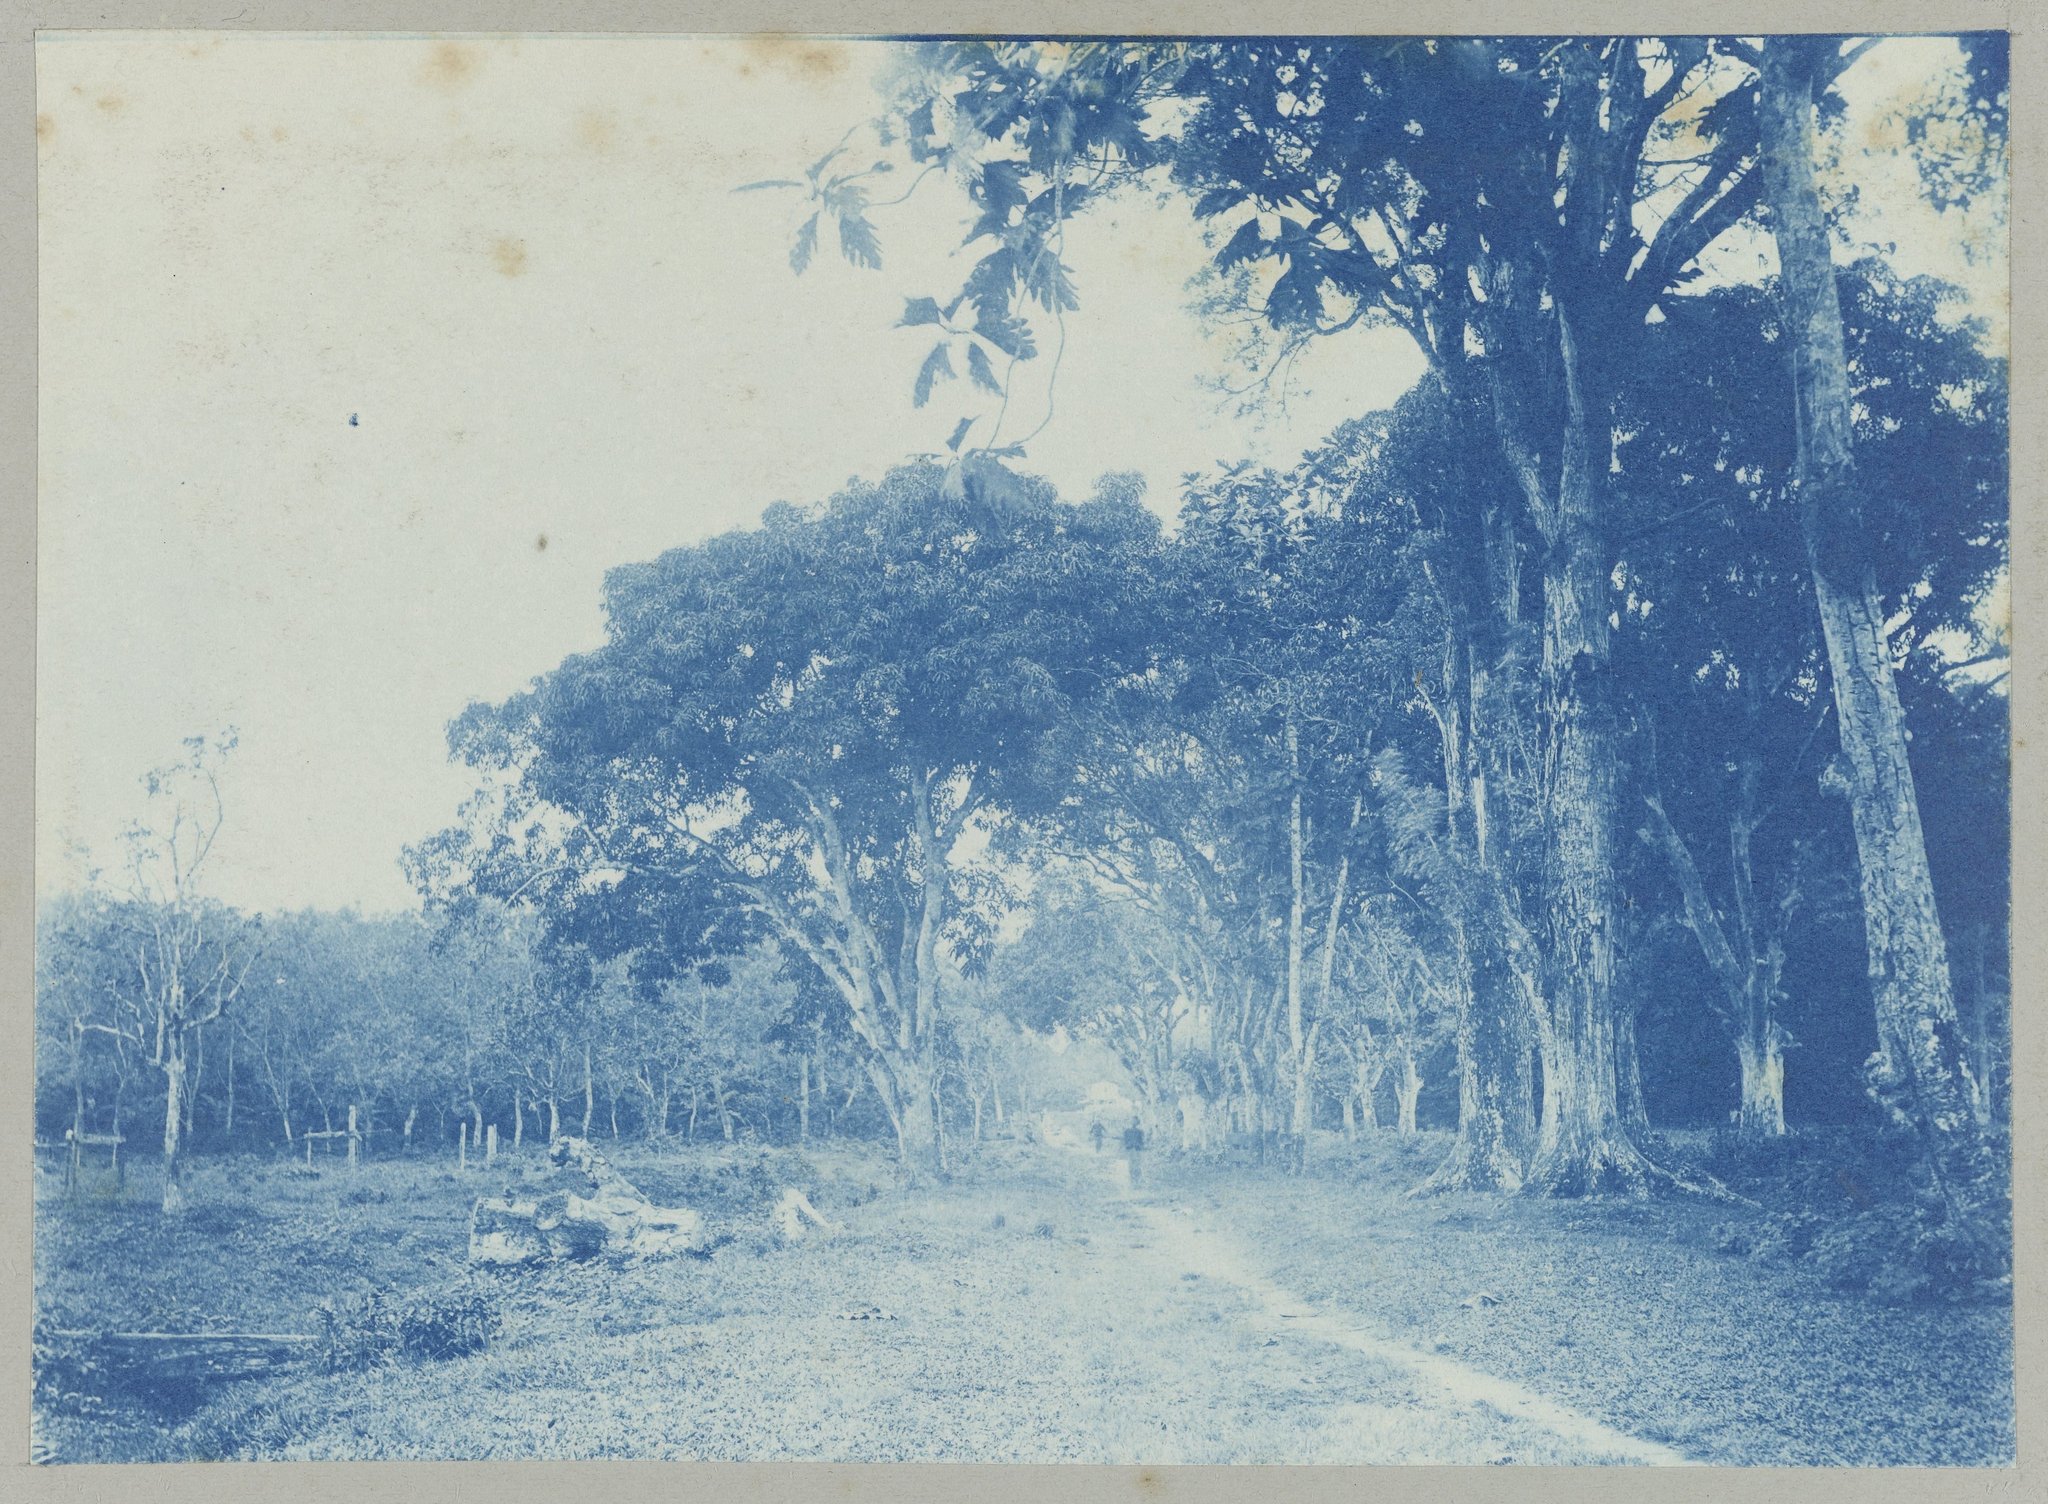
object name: photograph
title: Weg van "Ma retraite" naar de stad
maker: hendrik doijer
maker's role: engineer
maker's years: 1863-1925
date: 1903-1910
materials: photographic support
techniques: cyanotype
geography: suriname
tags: suriname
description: De weg van de plantage Ma Retraite naar Paramaribo. Onderdeel van het fotoalbum Souvenir de Voyage (deel 1), over het leven van de familie Doijer in en rond de plantage Ma Retraite in Suriname in de jaren 1903-1910.